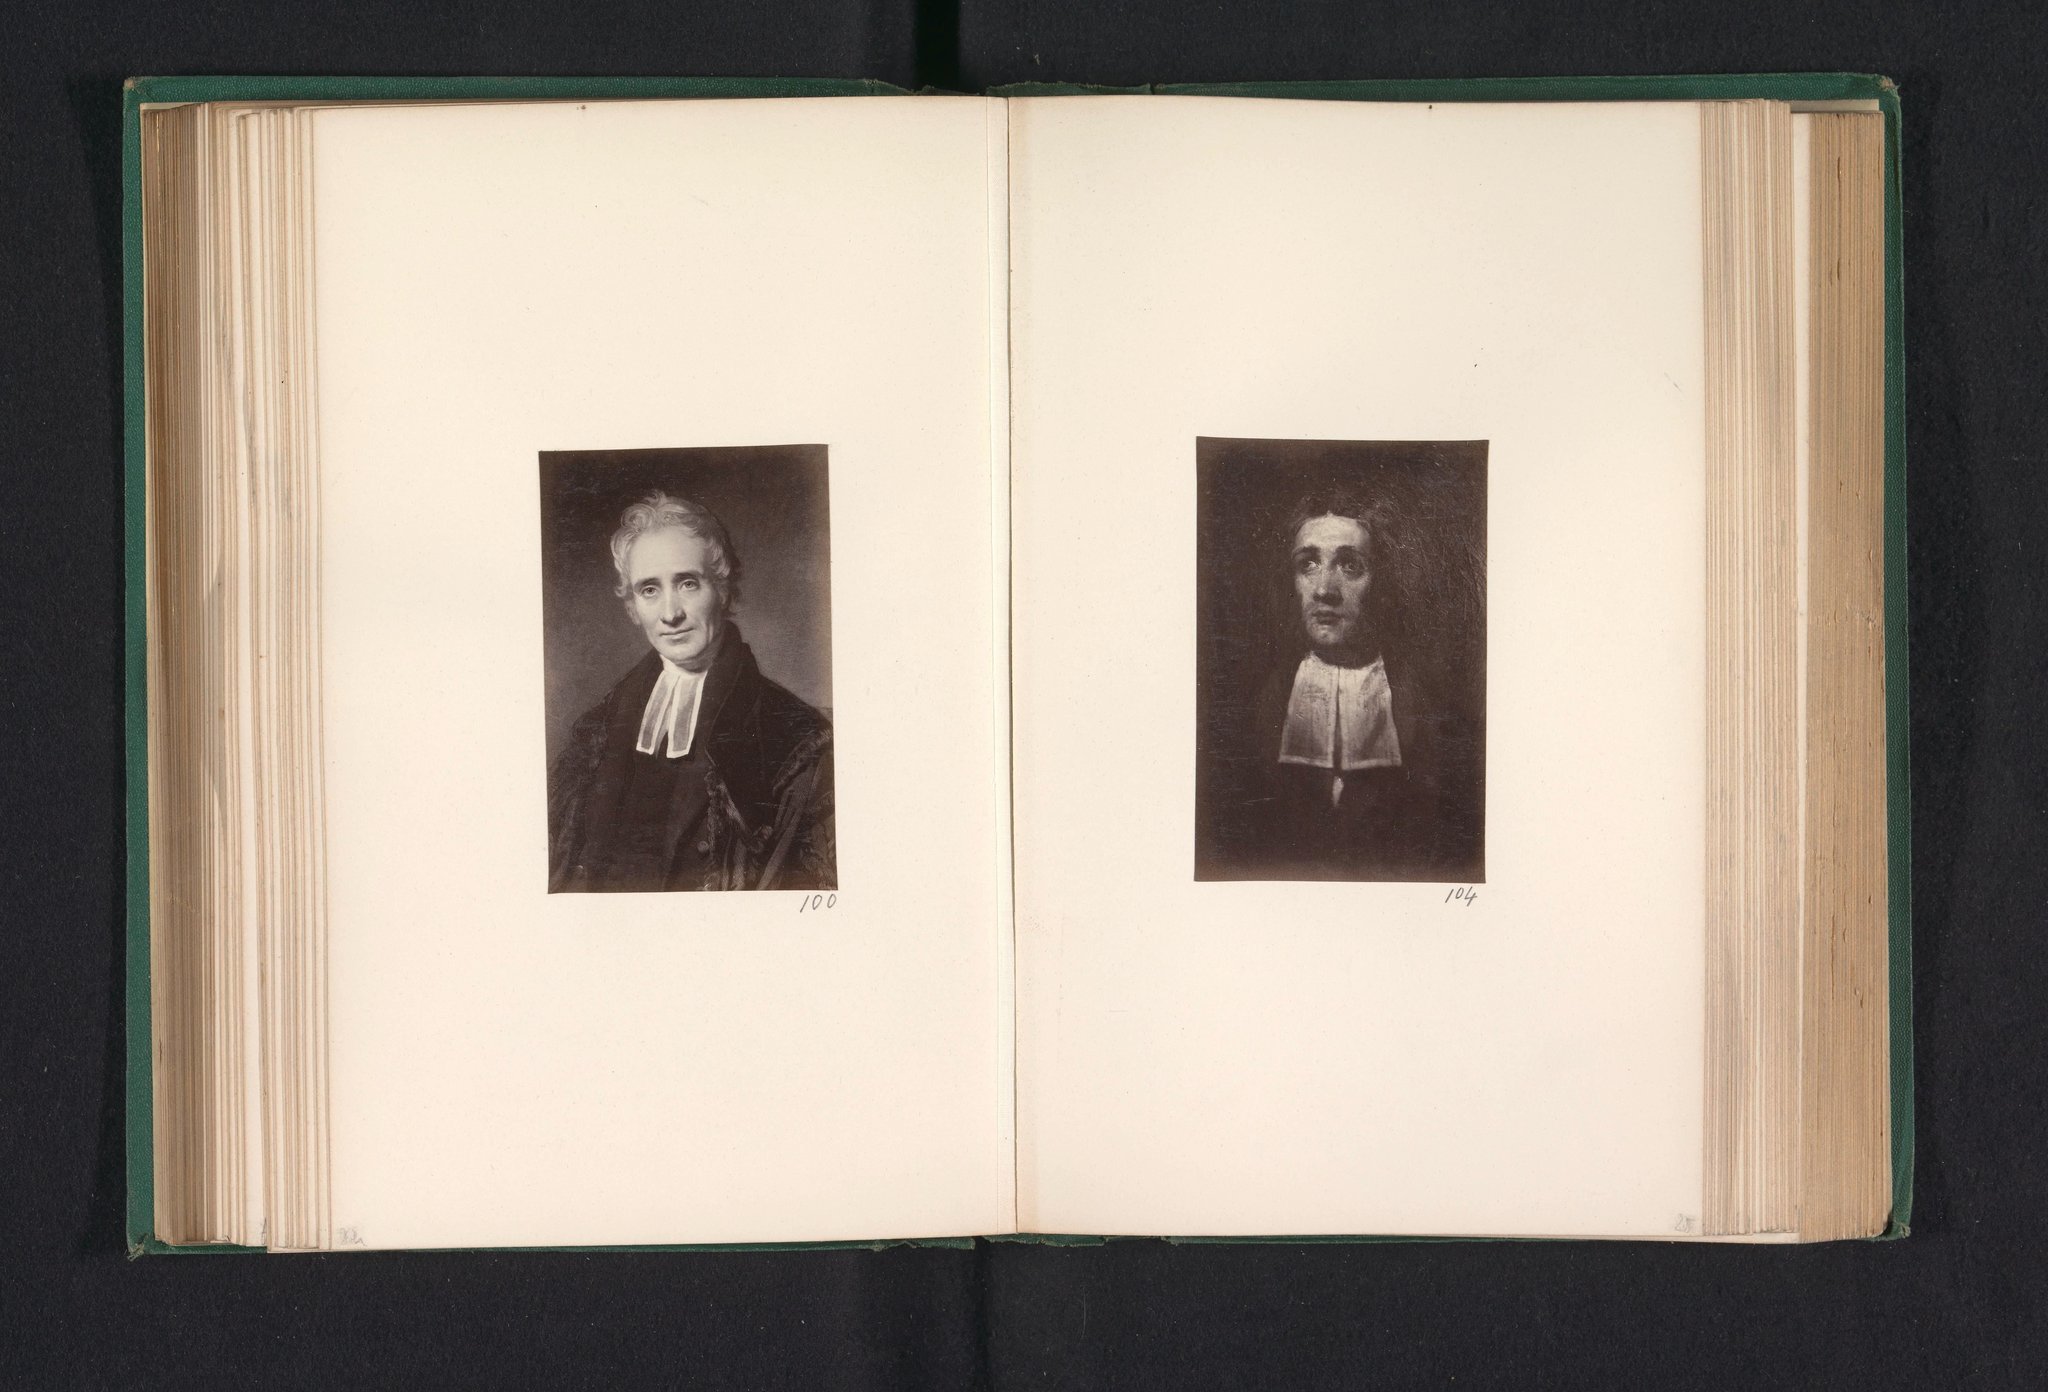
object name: page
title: Fotoreproductie van een schilderij, voorstellende een portret van Edward Irving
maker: thomas annan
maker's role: fotograaf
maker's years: 1829-1887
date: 1863-1868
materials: photographic support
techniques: albumen print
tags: clergyman, historical persons (portraits and scenes from the life) (+ (full) bust portrait)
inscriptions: number: ‘104’